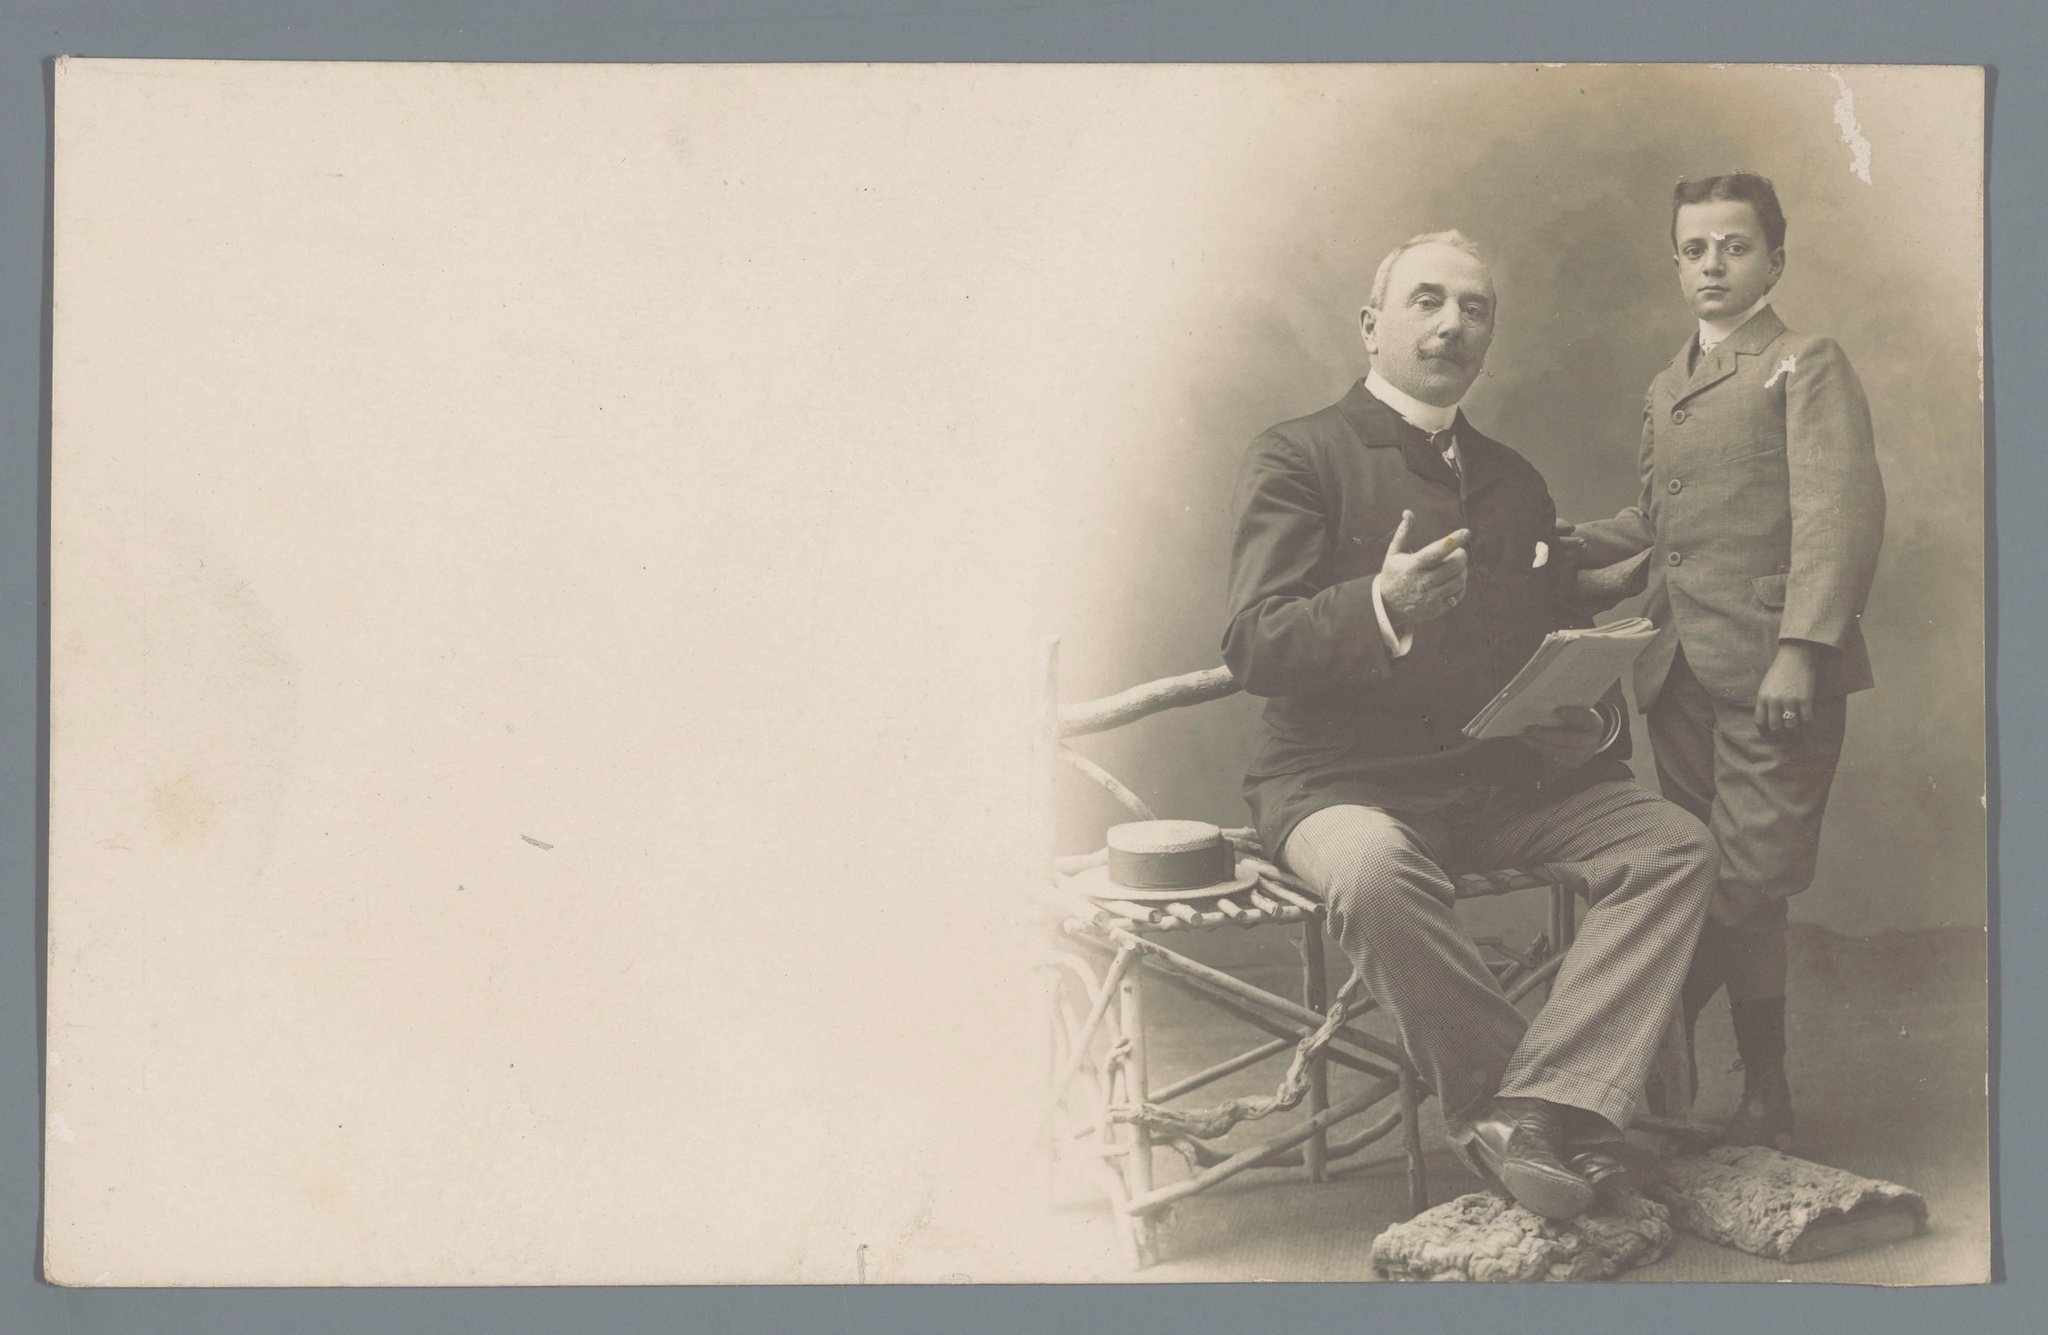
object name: ansichtkaart, prentbriefkaart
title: Studioportret van een onbekende oude man en een jongen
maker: francesco reale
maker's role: fotograaf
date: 1910-1925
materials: photographic support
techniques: gelatin silver print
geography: rome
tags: family group, especially parents with their child(ren)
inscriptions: inscription: ‘Studio Artistico Fotografico Francesco Reale Corso Vittorio Emanuele, 24 - Roma’